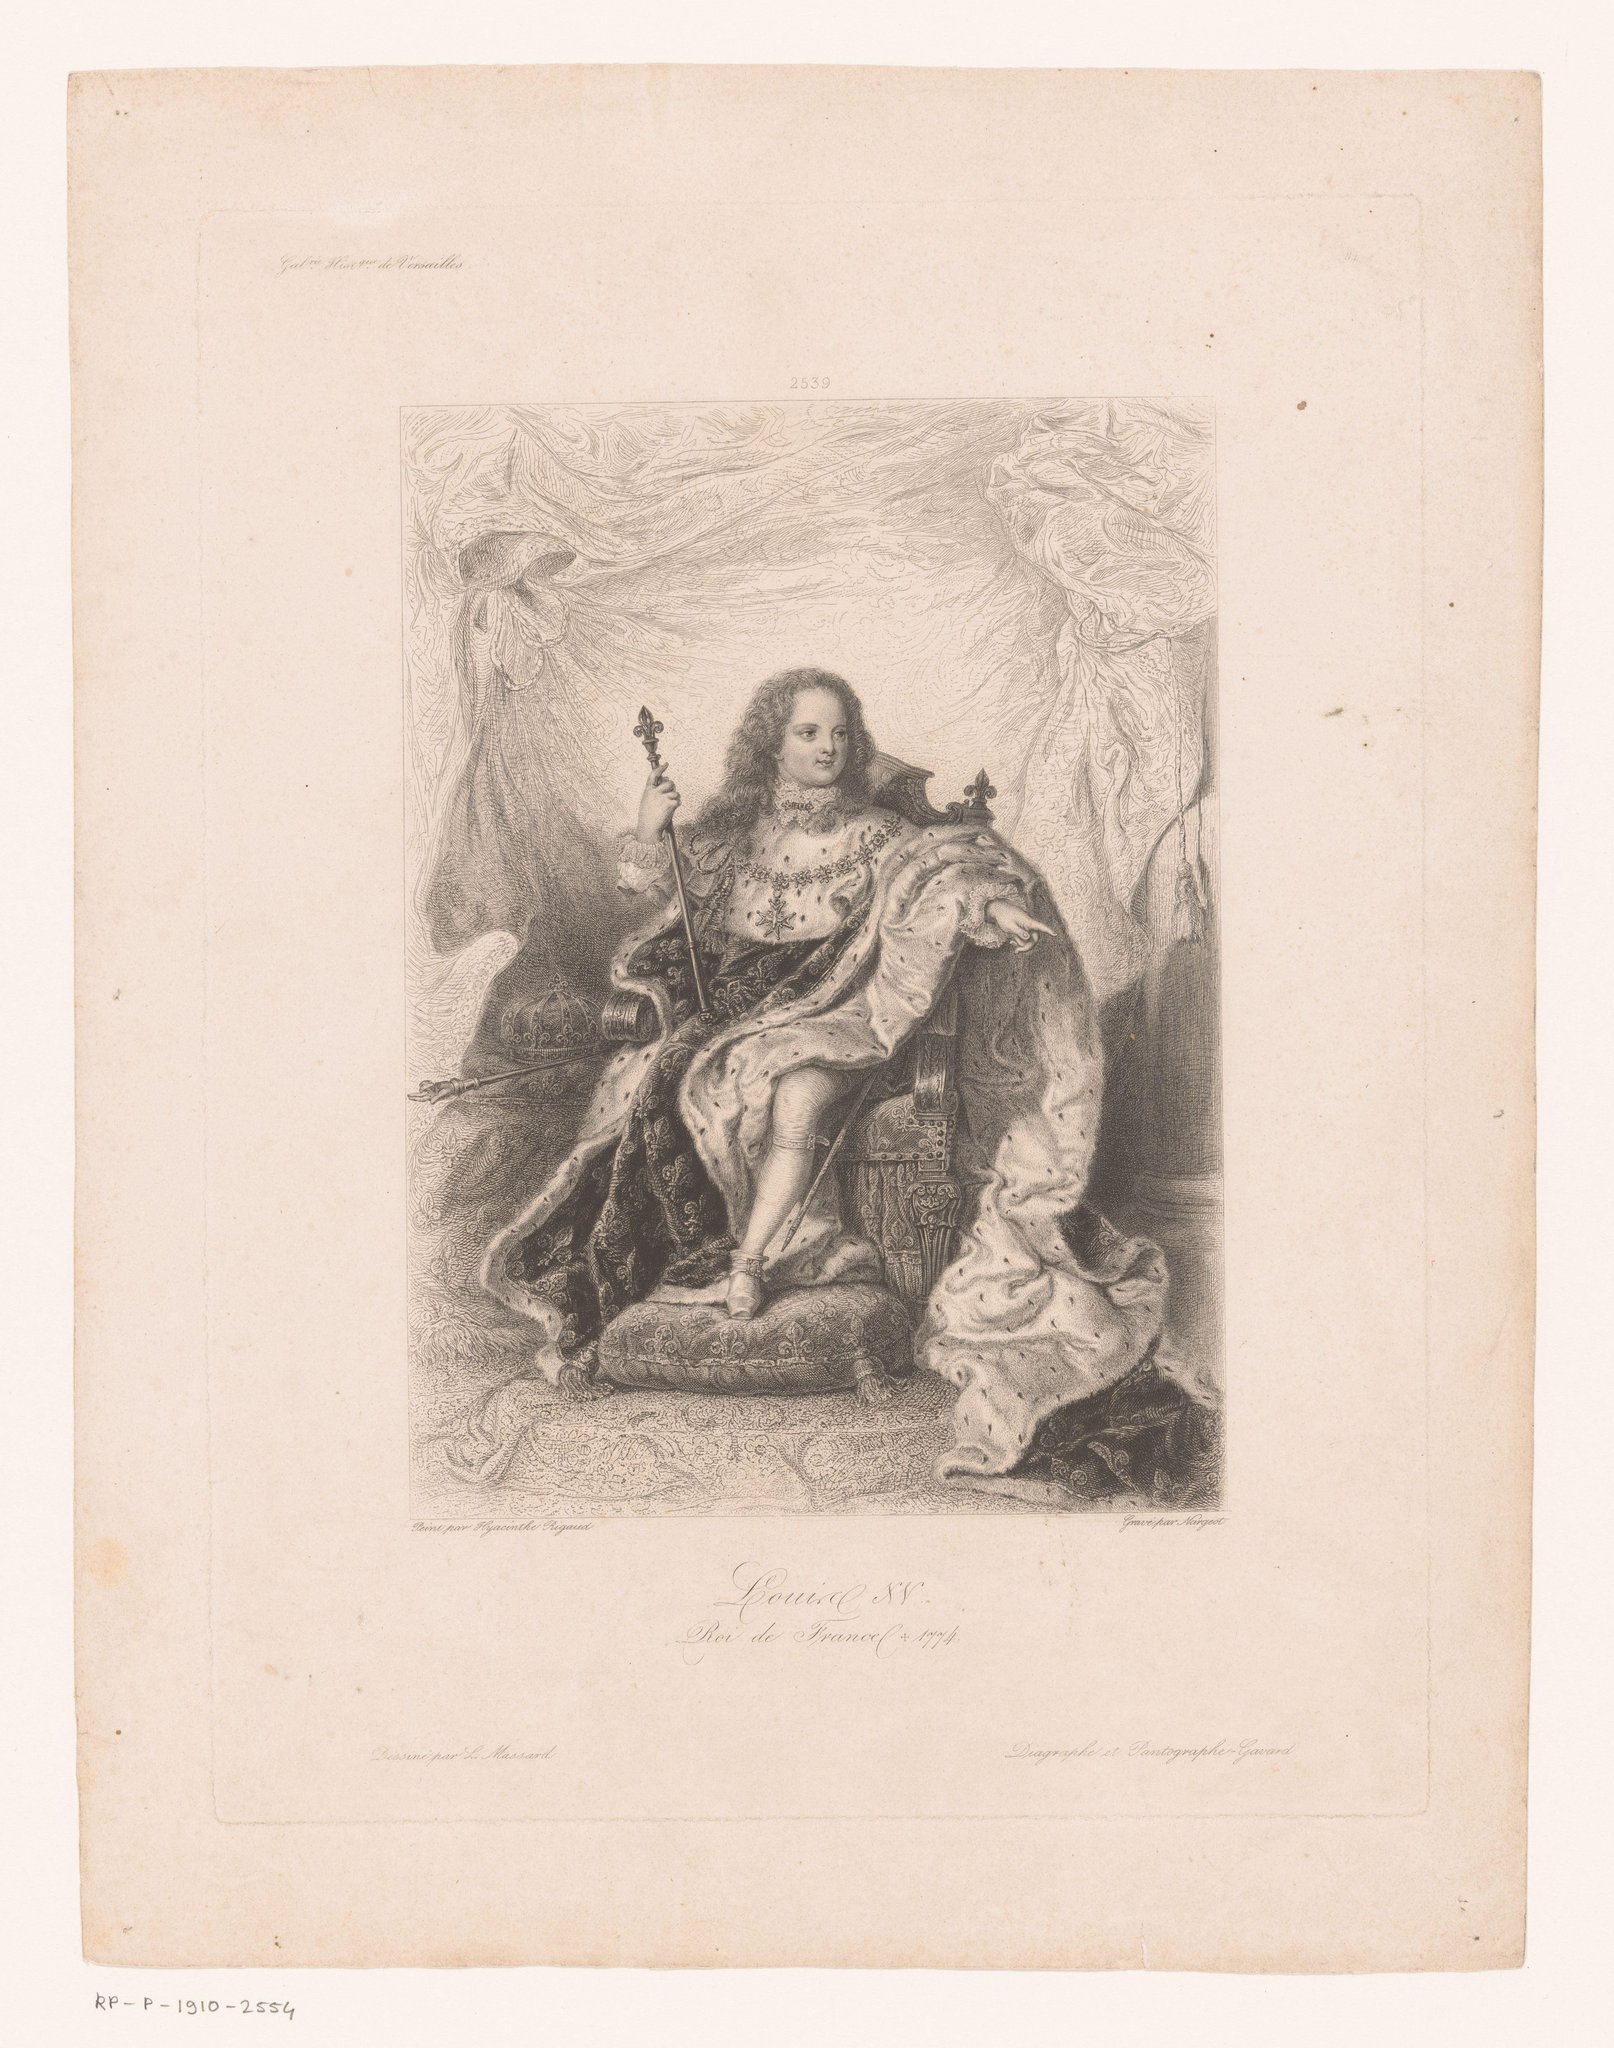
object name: book illustration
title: Louis XVI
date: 1838-1841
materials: paper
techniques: etching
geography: paris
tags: louis xv of france, historical persons, king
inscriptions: collector's mark: Lugt 2228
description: Prent uit: Galeries historiques de Versailles. Parijs: Charles Gavard, 1838-1841.